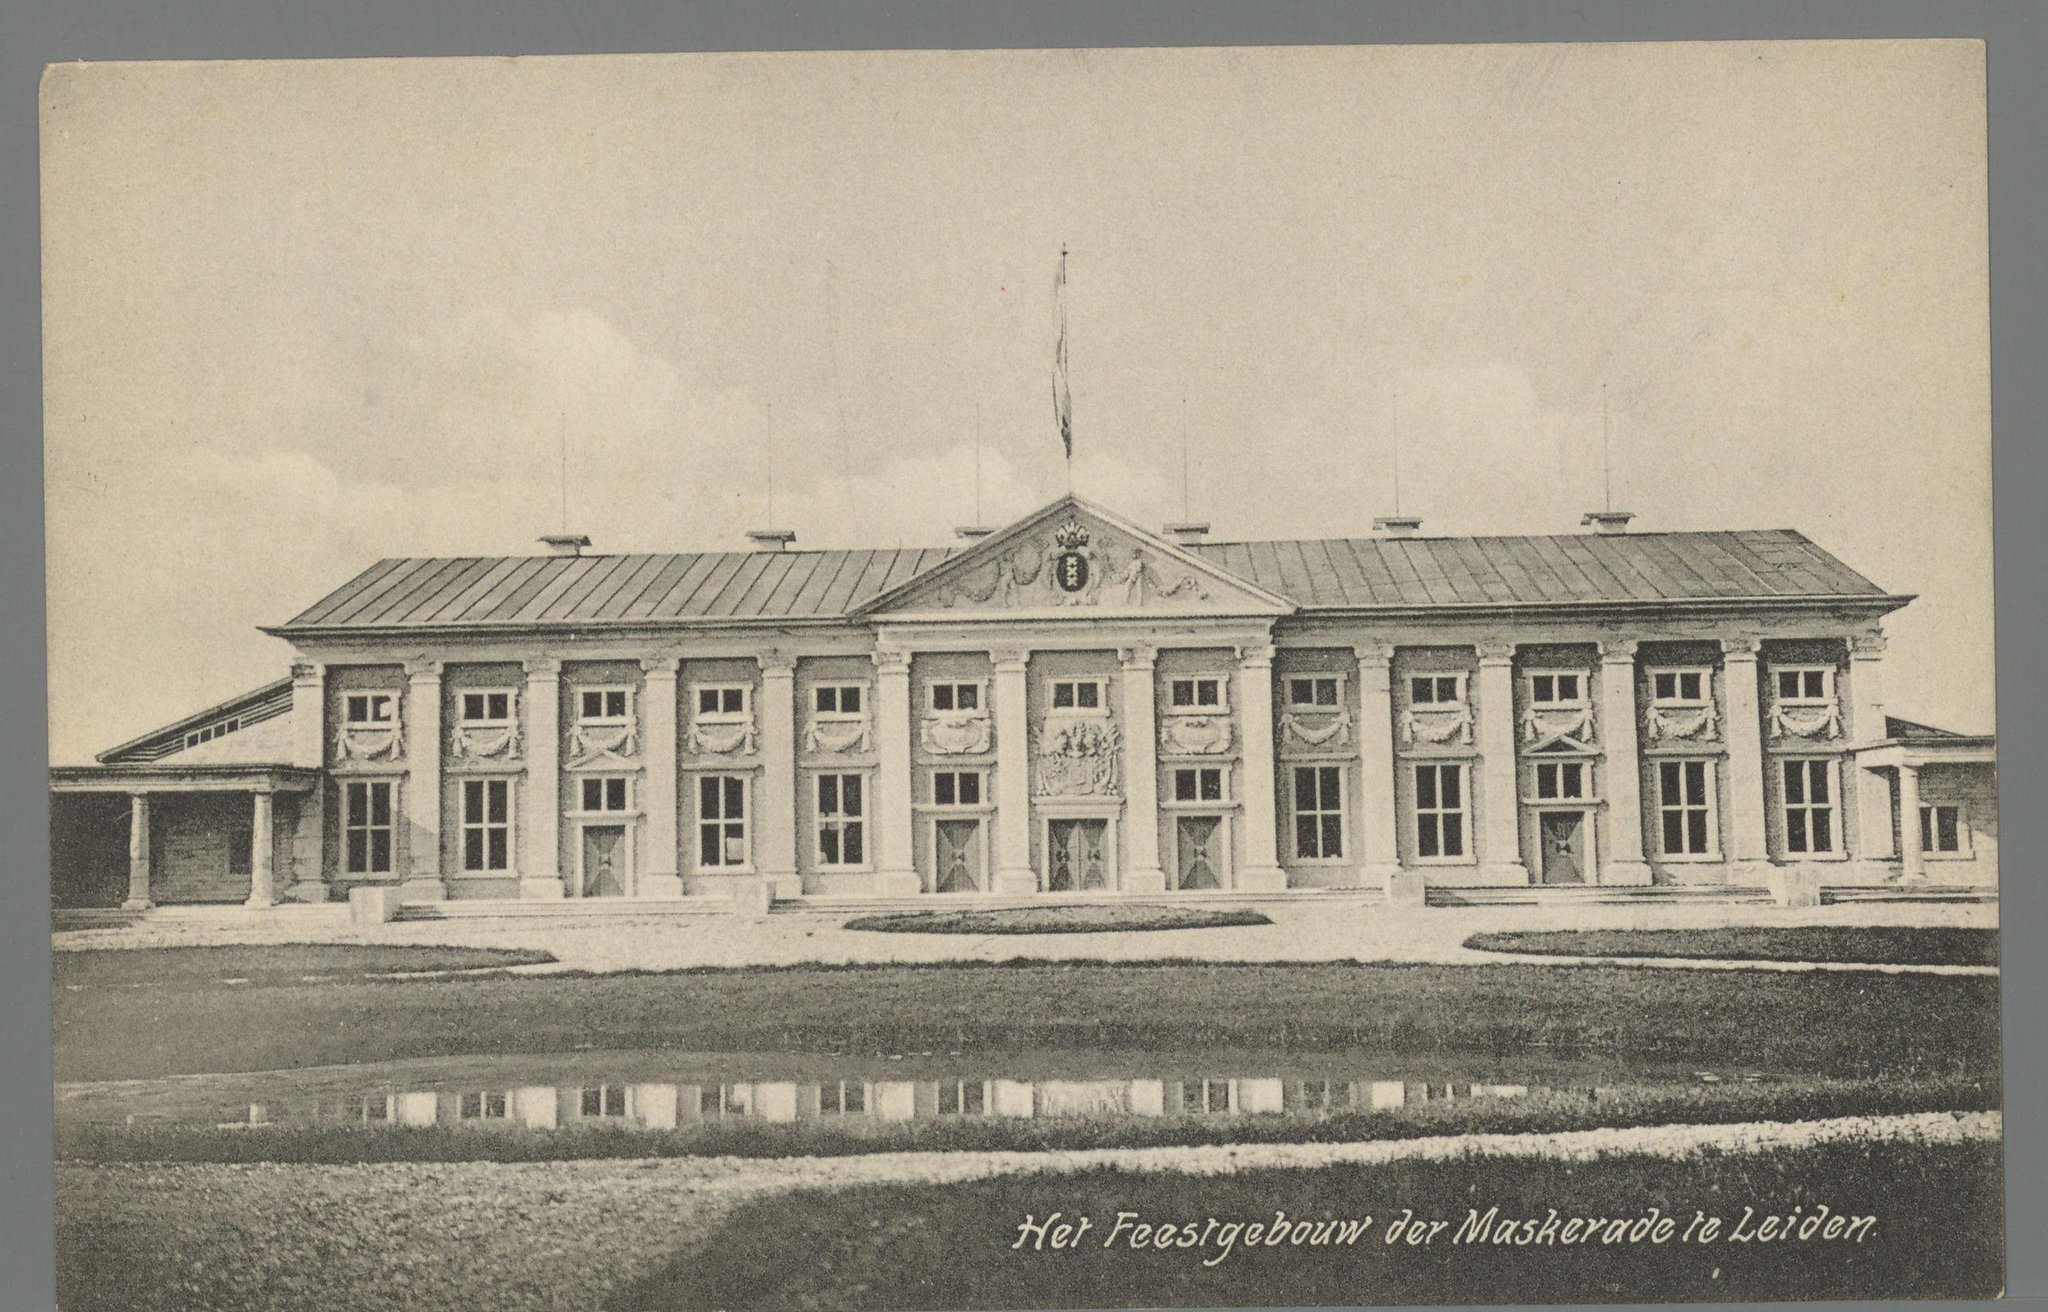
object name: photomechanical print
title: Het Feestgebouw der Maskerade te Leiden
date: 1910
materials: cardboard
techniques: photograph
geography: leiden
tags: masquerade, masked ball, commemoration, jubilee, leiden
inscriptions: date